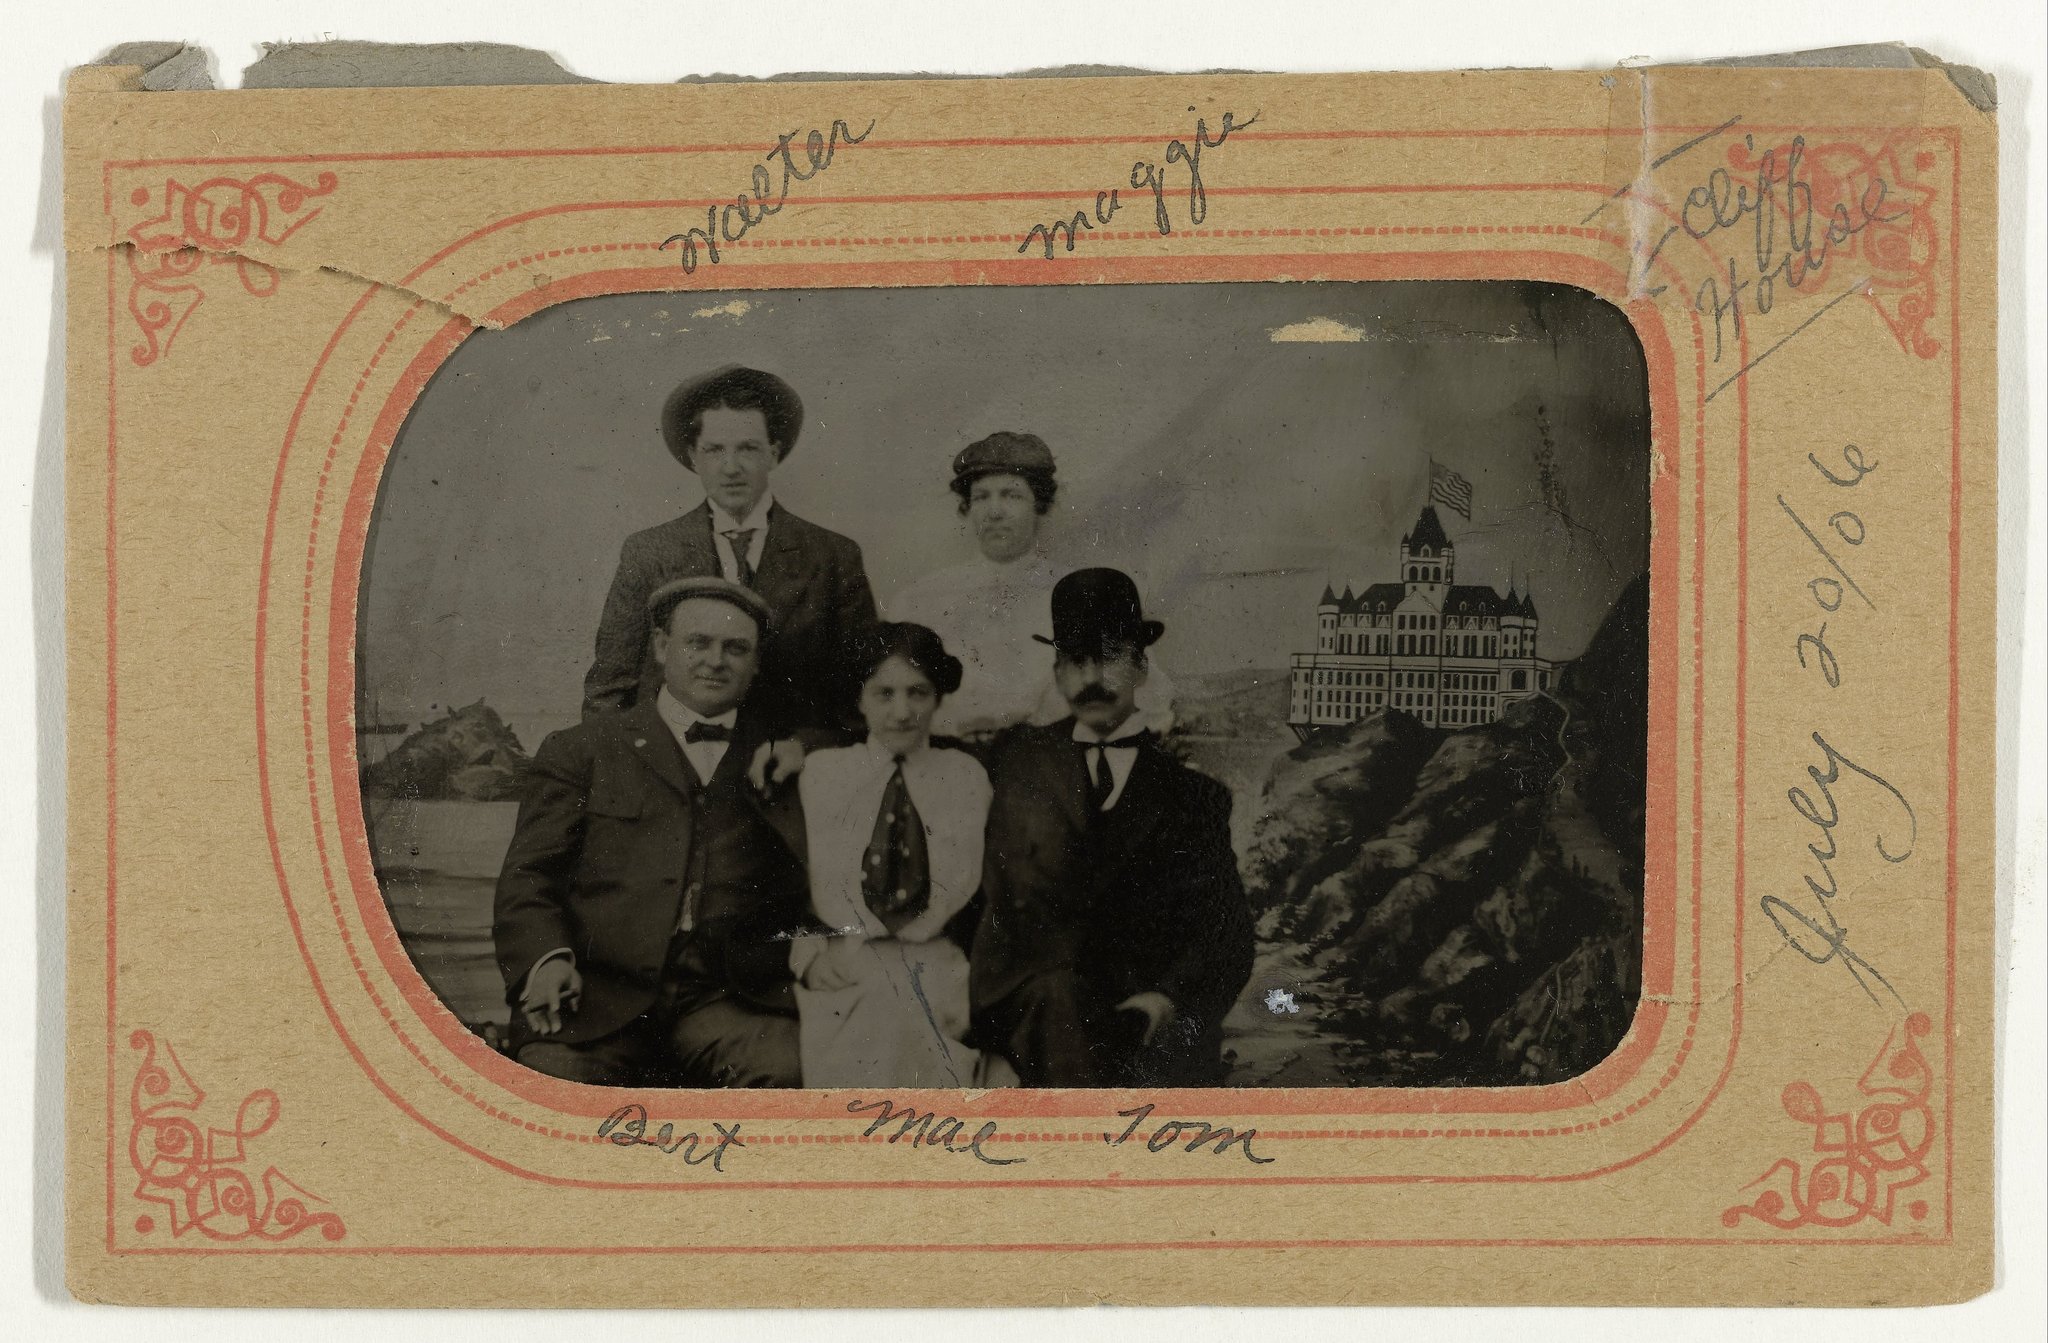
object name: photograph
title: Groepsportret van drie mannen en twee vrouwen voor een geschilderd achtergronddoek met Cliff House, bij San Francisco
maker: Anonymous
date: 1904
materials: metal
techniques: ferrotyping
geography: united states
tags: anonymous historical person portrayed, anonymous historical person portrayed - bb - woman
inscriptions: annotation: ‘Walter // Maggie // Clifton House // July 20/04 // Bert // Mae // Tom’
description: Groepsportret van drie mannen en twee vrouwen voor een geschilderd achtergronddoek met Cliff House, bij San Francisco. In een papieren passpartout.